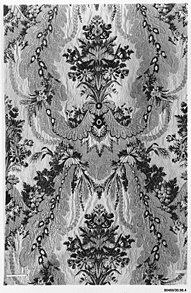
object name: piece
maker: lazareff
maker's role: manufactory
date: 1701-1800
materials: metal thread, silk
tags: flowers